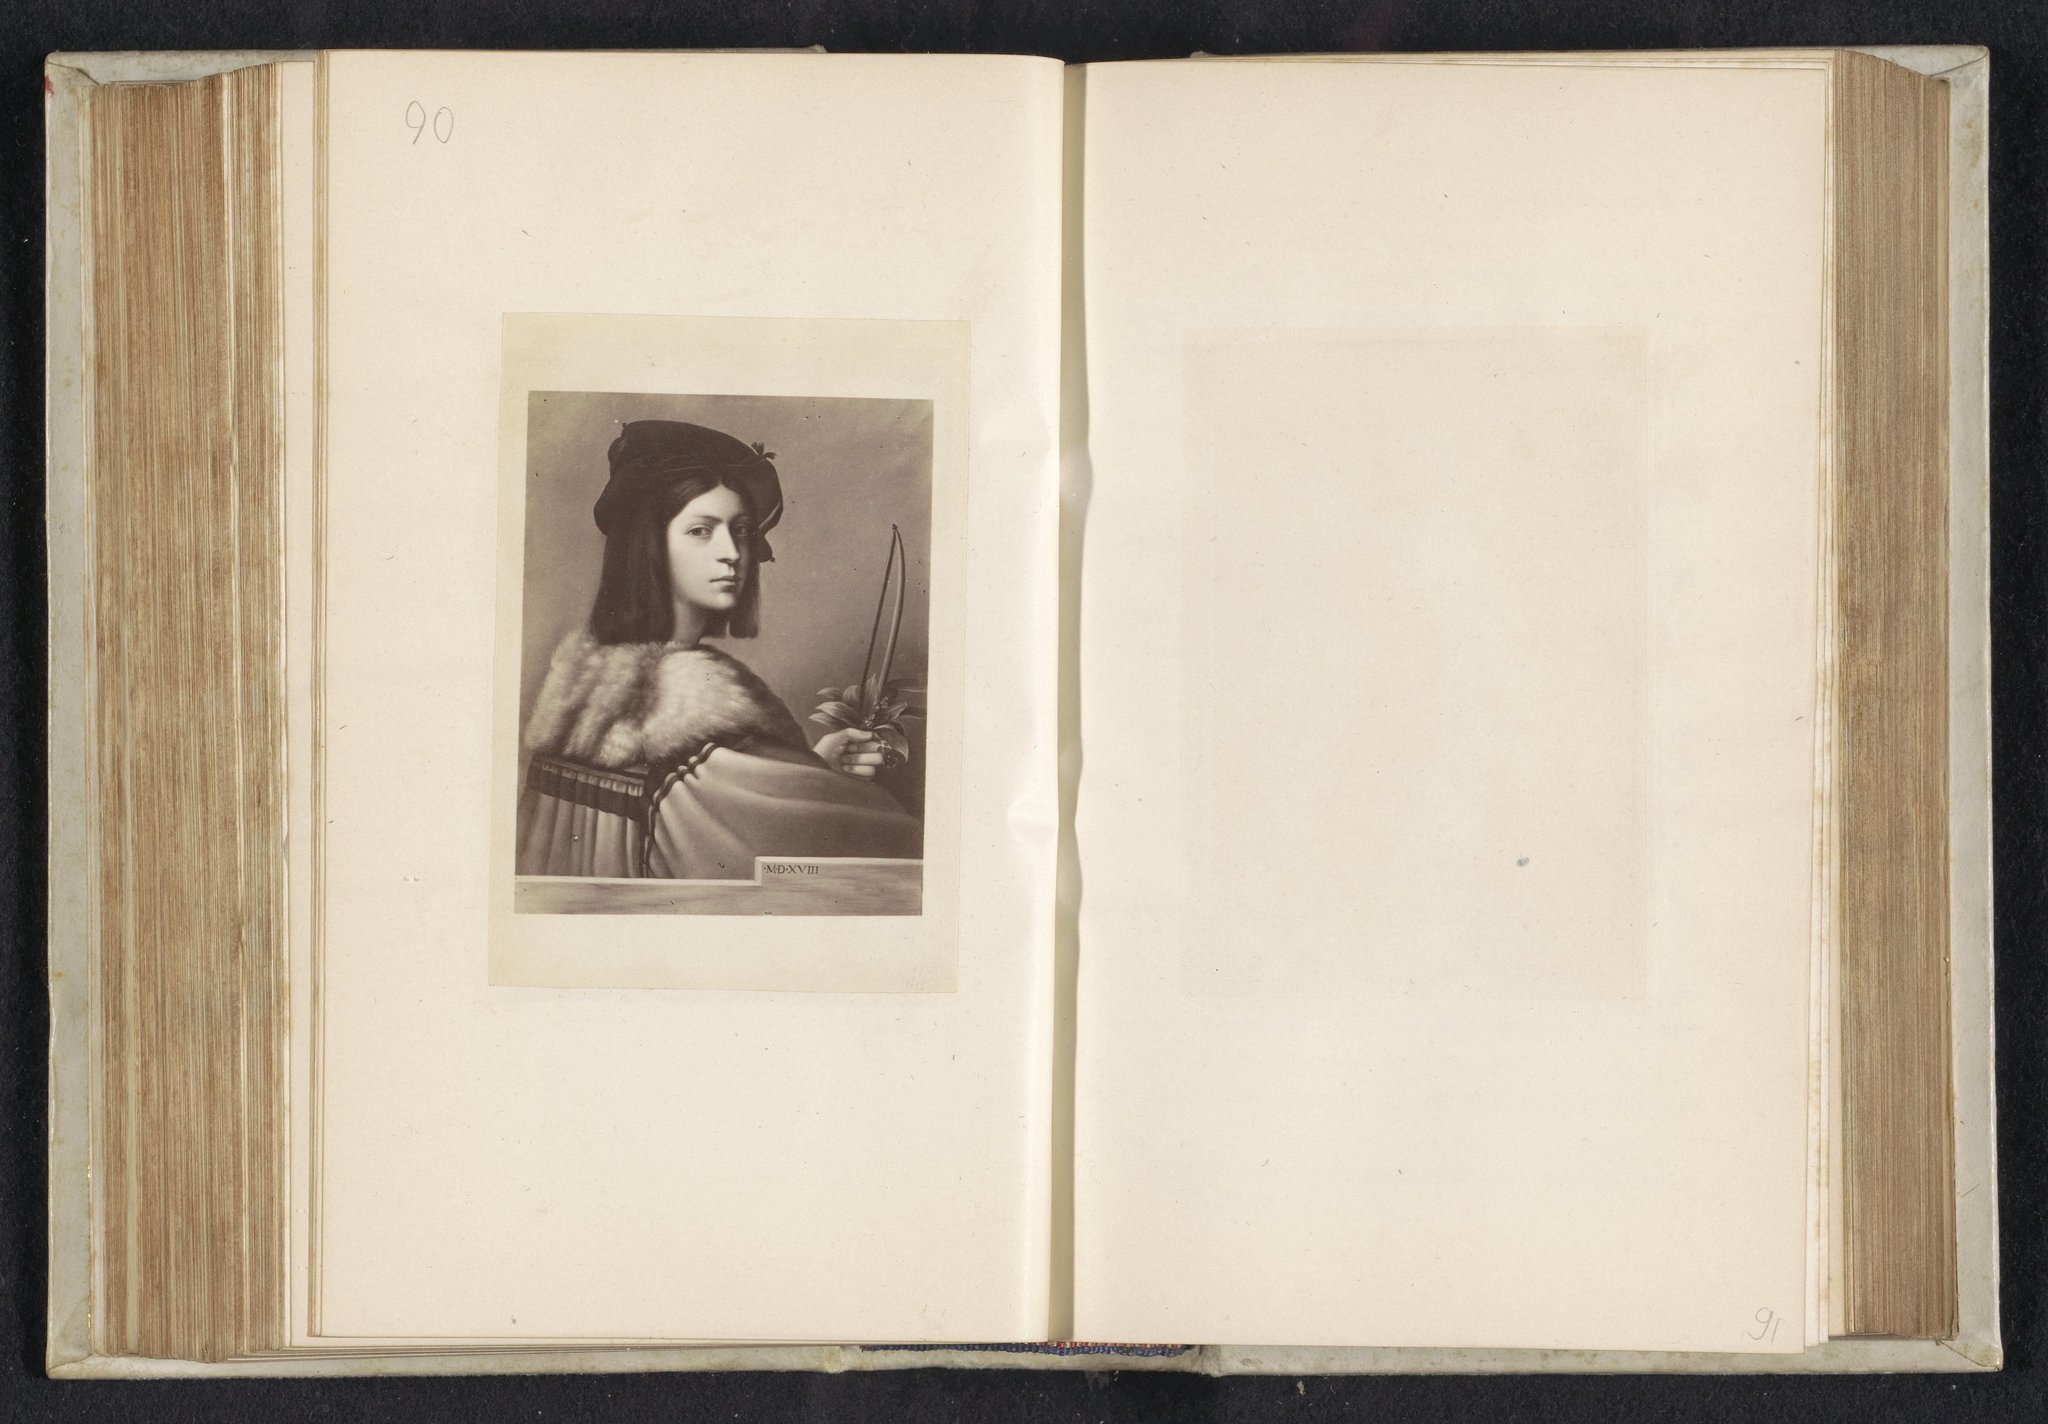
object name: reproduction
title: Fotoreproductie van een schilderij, voorstellende een portret van een onbekende man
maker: Anonymous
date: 1850-1860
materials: photographic support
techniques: albumen print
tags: head-gear, adult man, historical persons not known by name